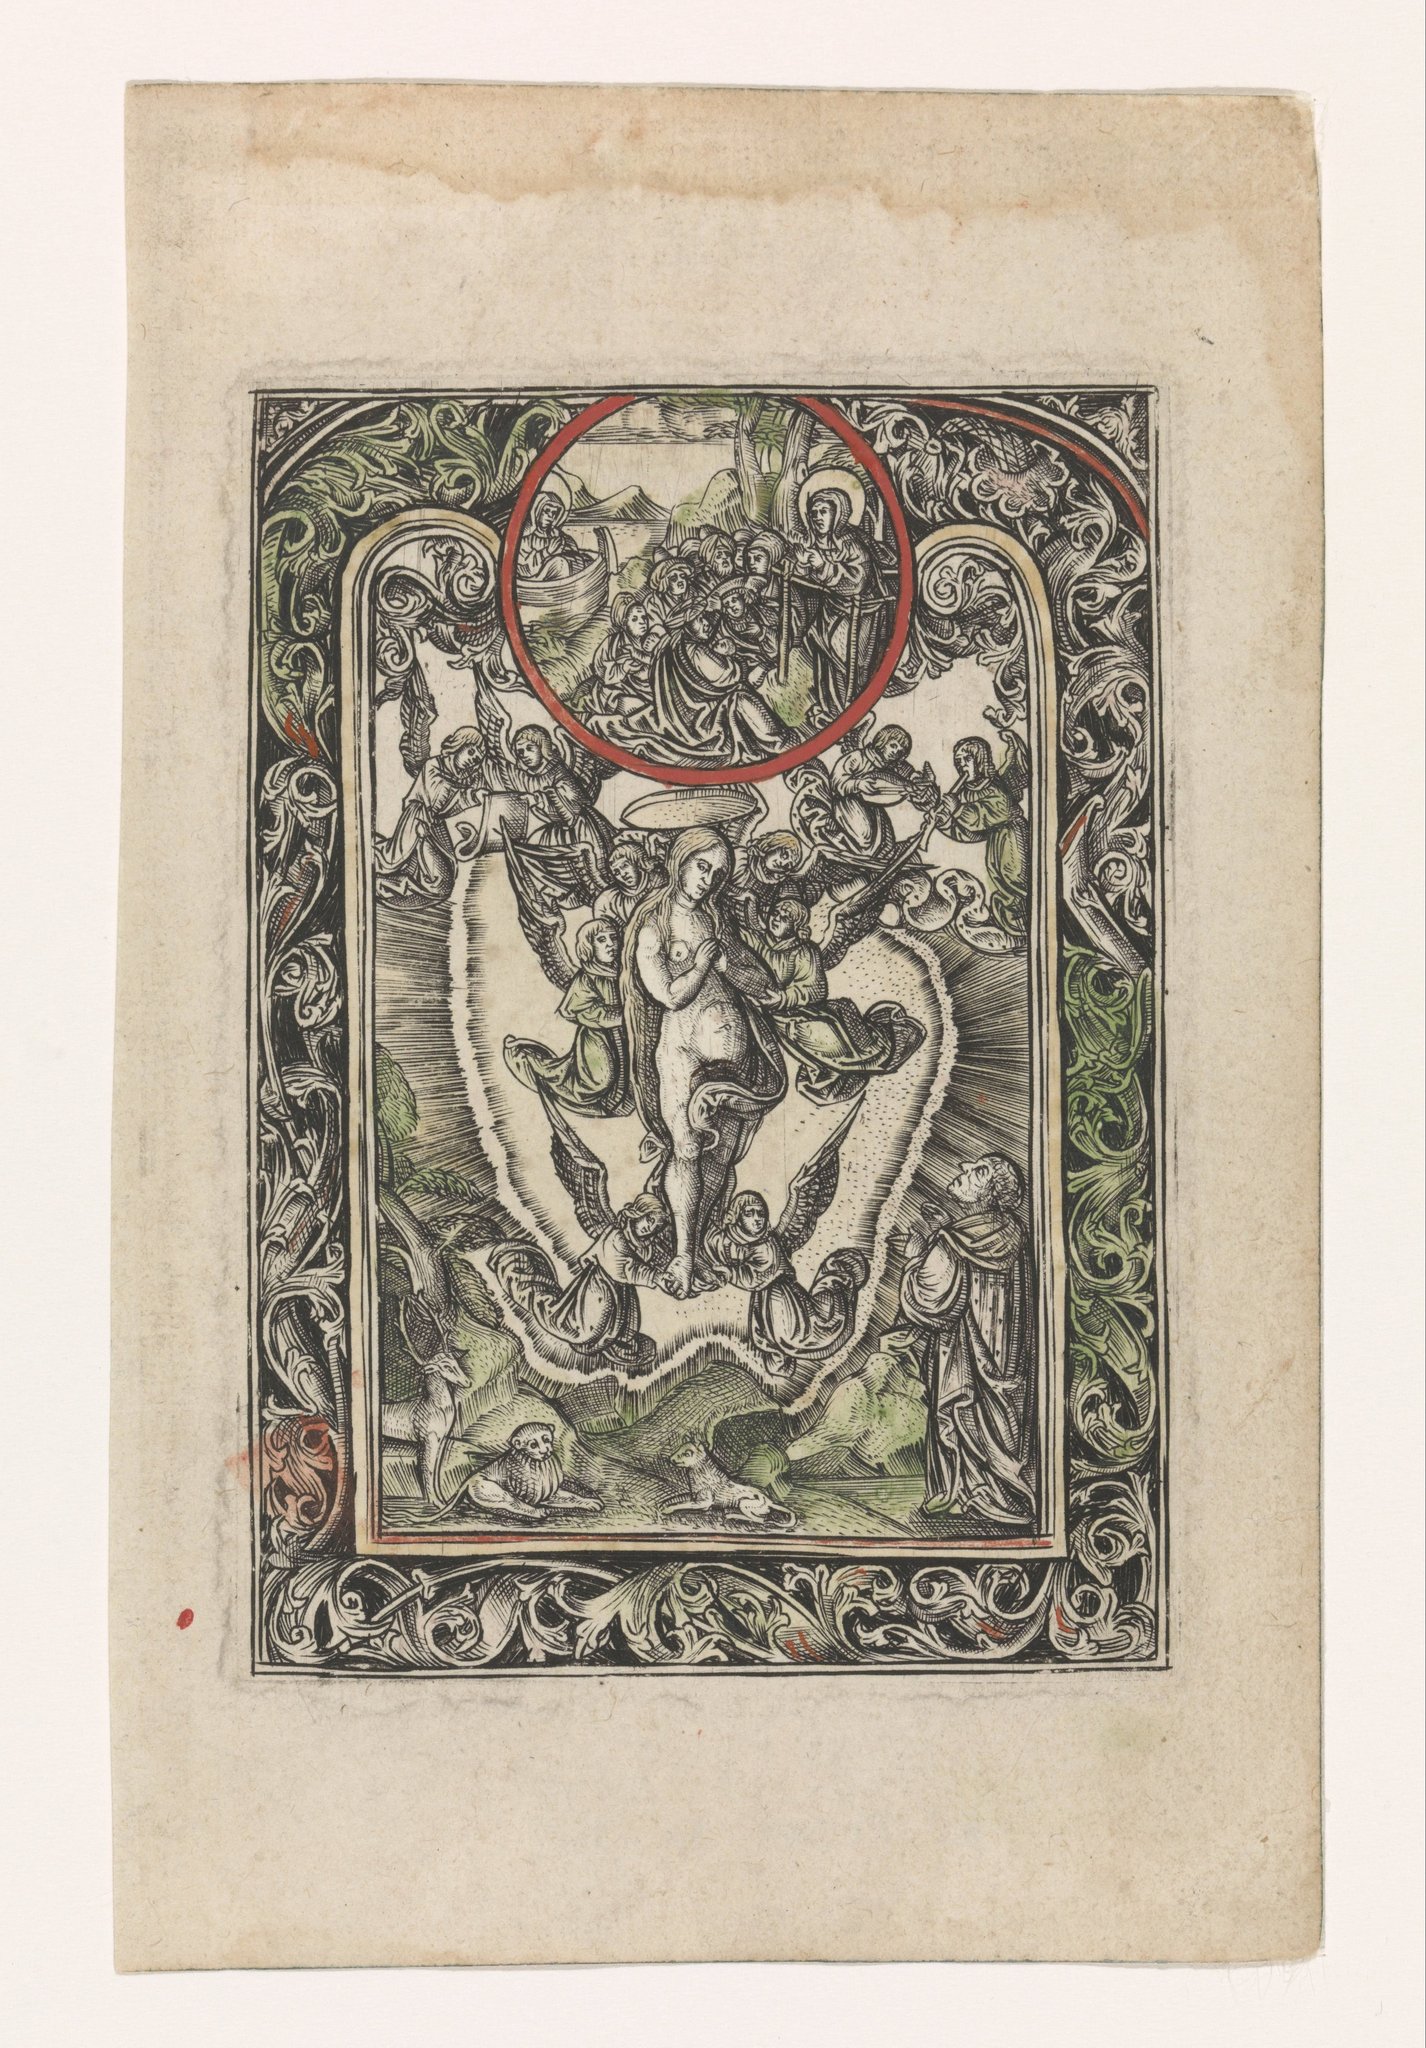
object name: print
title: The Assumption of Mary Magdalene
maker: meester s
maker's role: print maker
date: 1530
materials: paper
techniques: engraving, hand coloring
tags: the penitent harlot mary magdalene; possible attributes: book (or scroll), crown, crown of thorns, crucifix, jar of ointment, mirror, musical instrument, palm-branch, rosary, scourge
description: Two scenes from the life of Mary Magdalene have been depicted in a beautiful ornamental border. At the top the former sinner preaches to penitent followers. In the middle the near-nude saint is being borne to heaven by angels, while a kneeling priest and three animals look on.